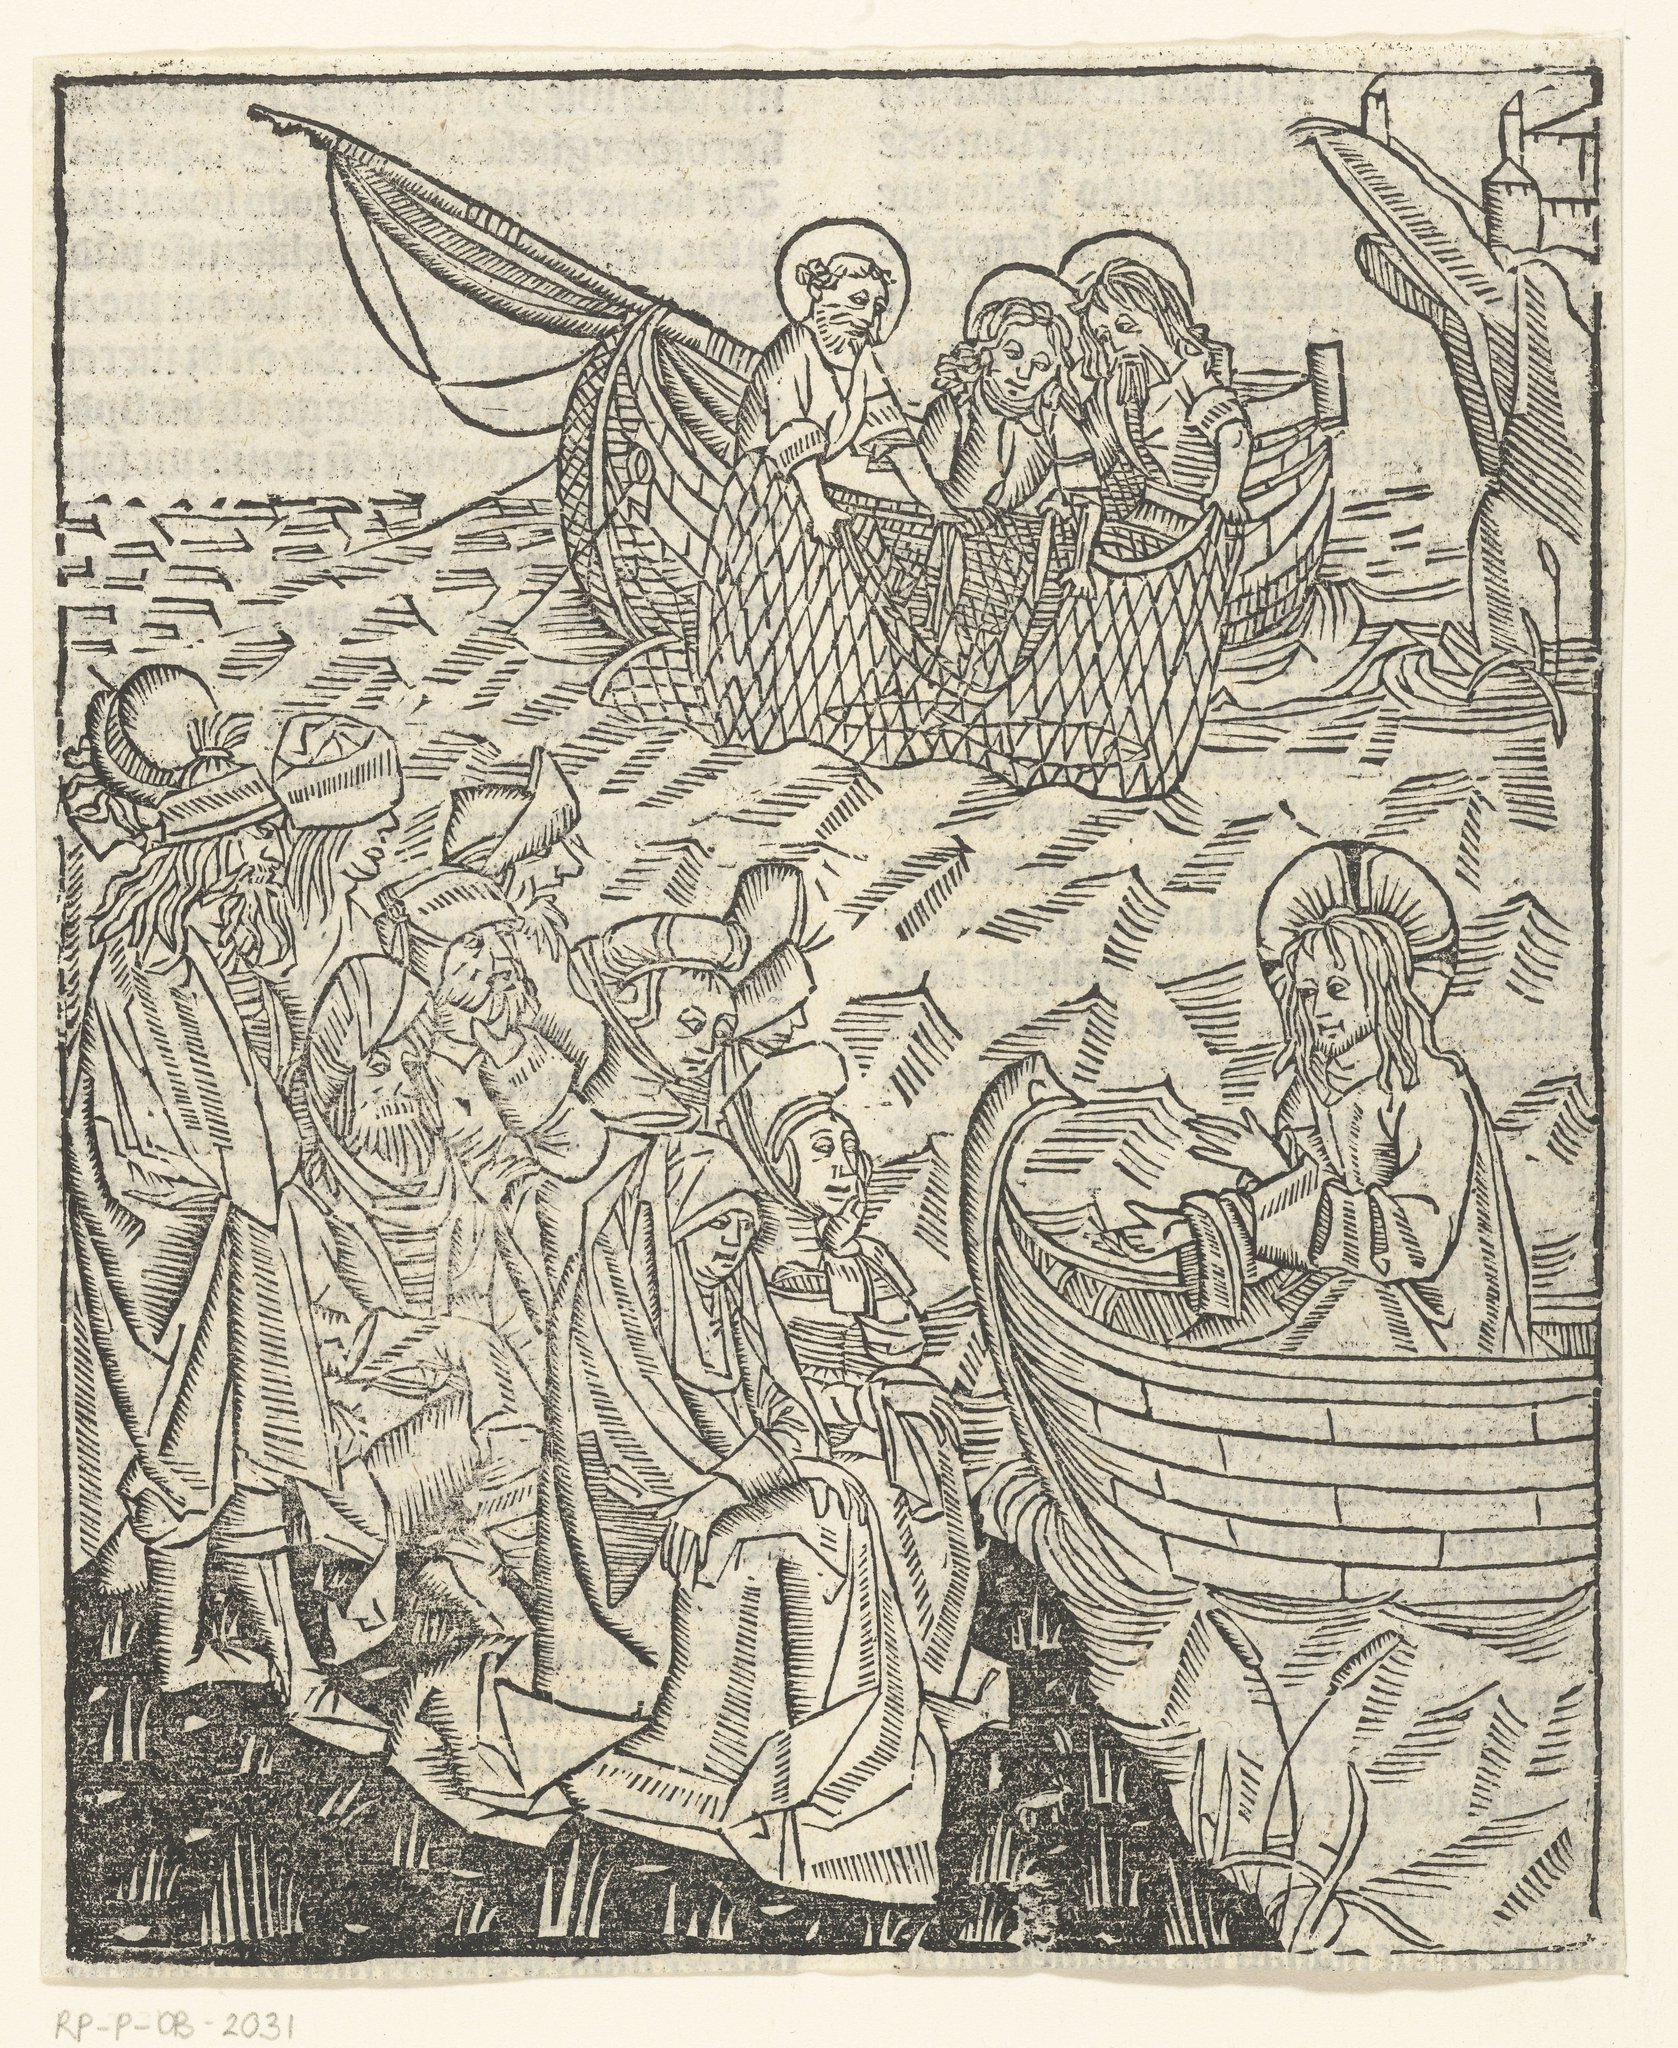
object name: print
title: Christus predikt vanuit een boot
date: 1480-1500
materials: paper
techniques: woodcut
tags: christ preaching from a boat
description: Eén blad van 113 uit Ludolphus de Saxonia, "Dit es dleué ons liefs heeren ihesu christi". Anonieme Nederlandse vertaling. Uitgegeven door Henrick Eckert van Homberch te Antwerpen in 1503. Botke, K. Deze 113 houtsneden, die meestal reeds in vroege Nederlandse boeken gebruikt zijn, worden toegeschreven aan de tweede Meester van Delft, de Meester van de Delbecq-Schreiber-passie en de Meester van de Virgo inter Virgines. In Conway (1884) en in "De gulden passer"(1951) zijn ook eerdere versies opgenomen. Botke, K.